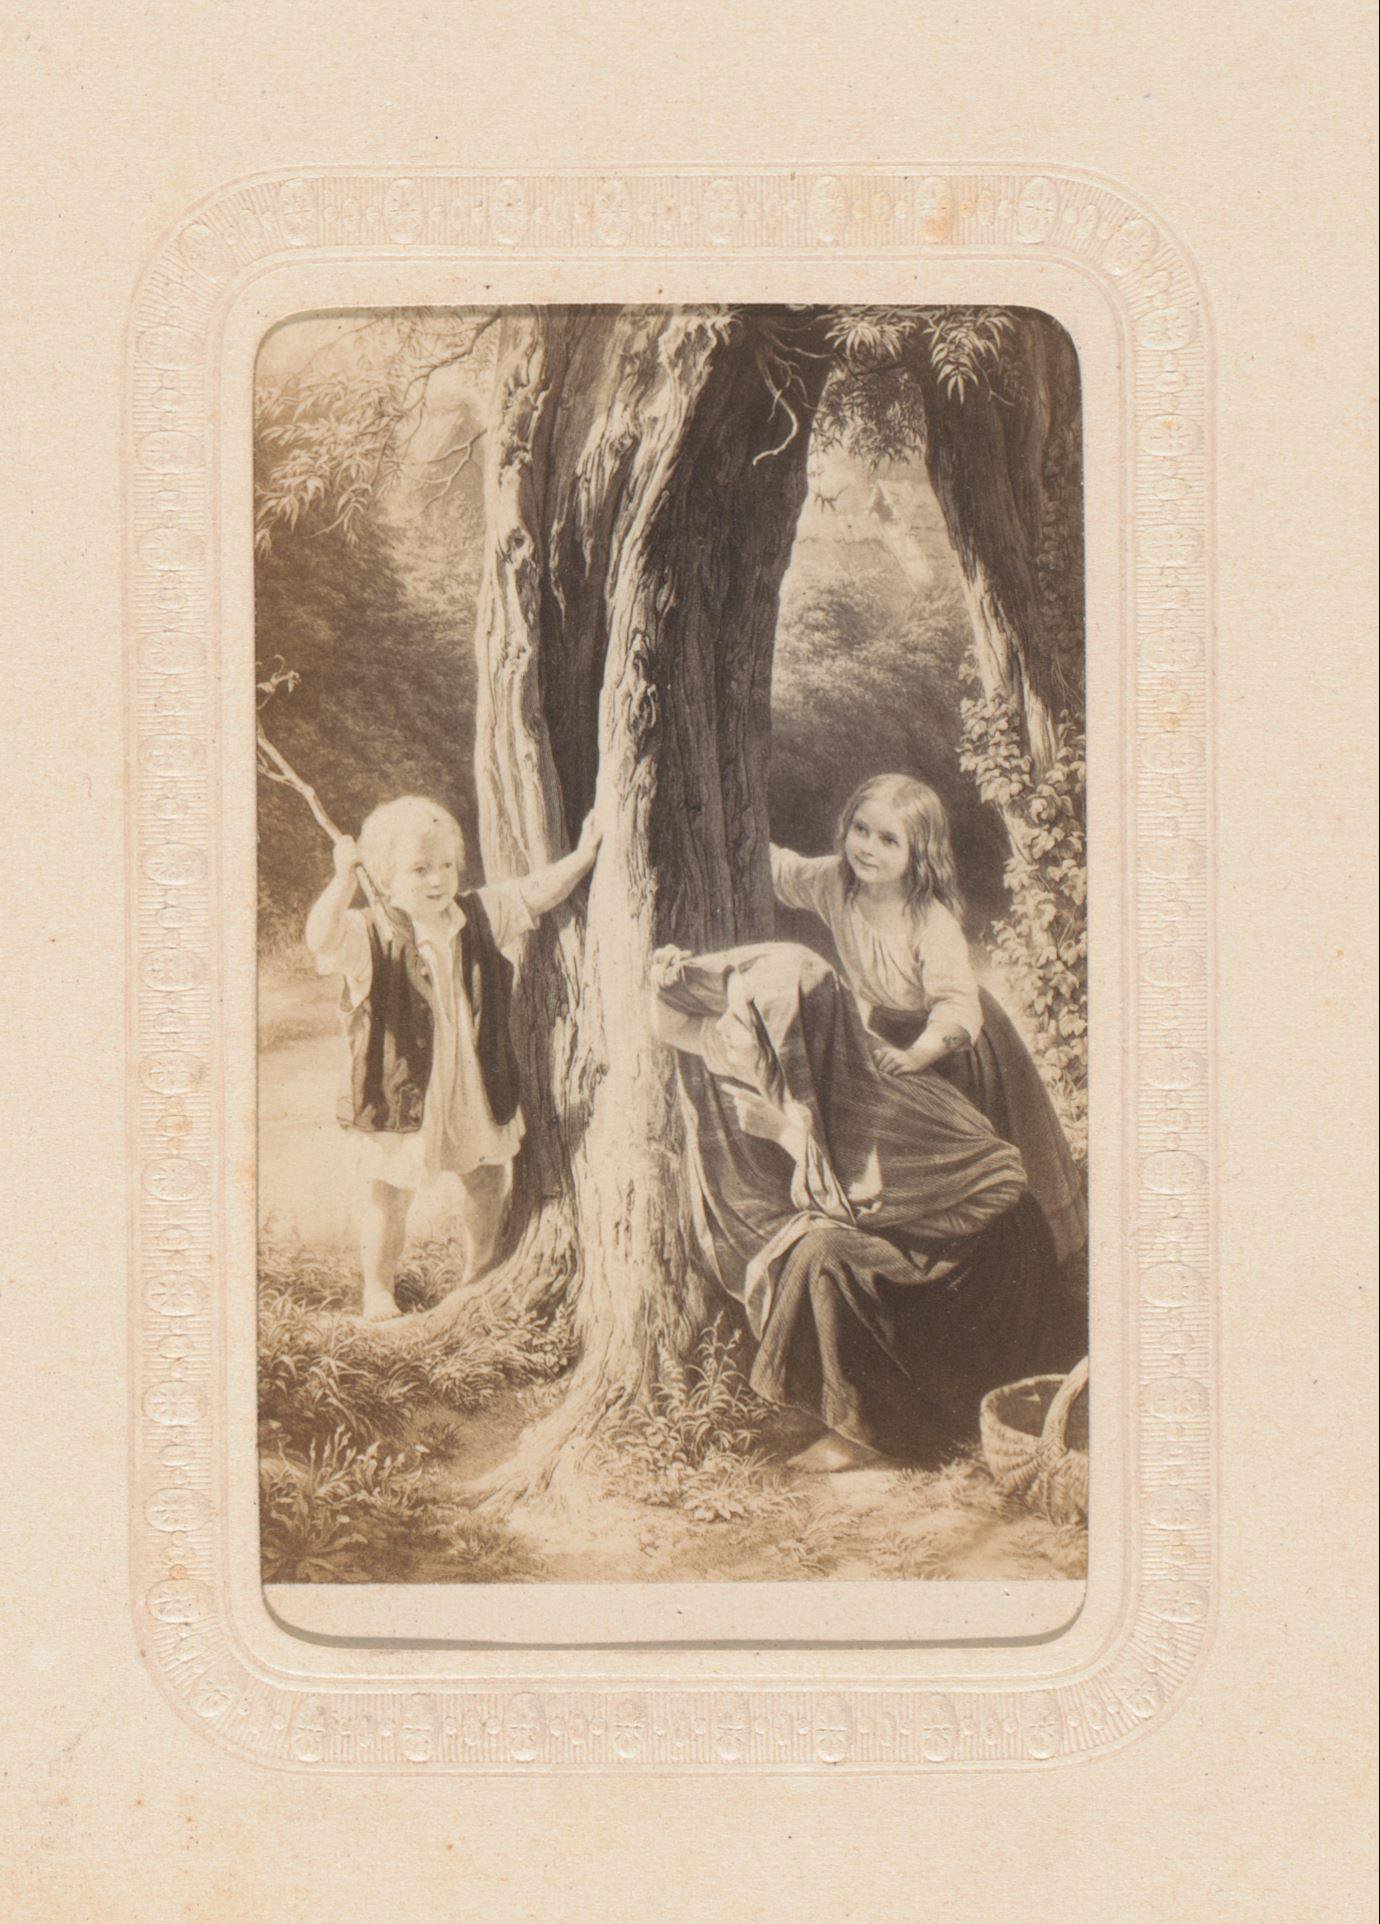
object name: photograph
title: Fotoreproductie van een schilderij met drie spelende kinderen in het bos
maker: Anonymous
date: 1855-1865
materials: cardboard, photographic support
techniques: albumen print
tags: hide-and-seek, boy (child between toddler and youth), girl (child between toddler and youth)